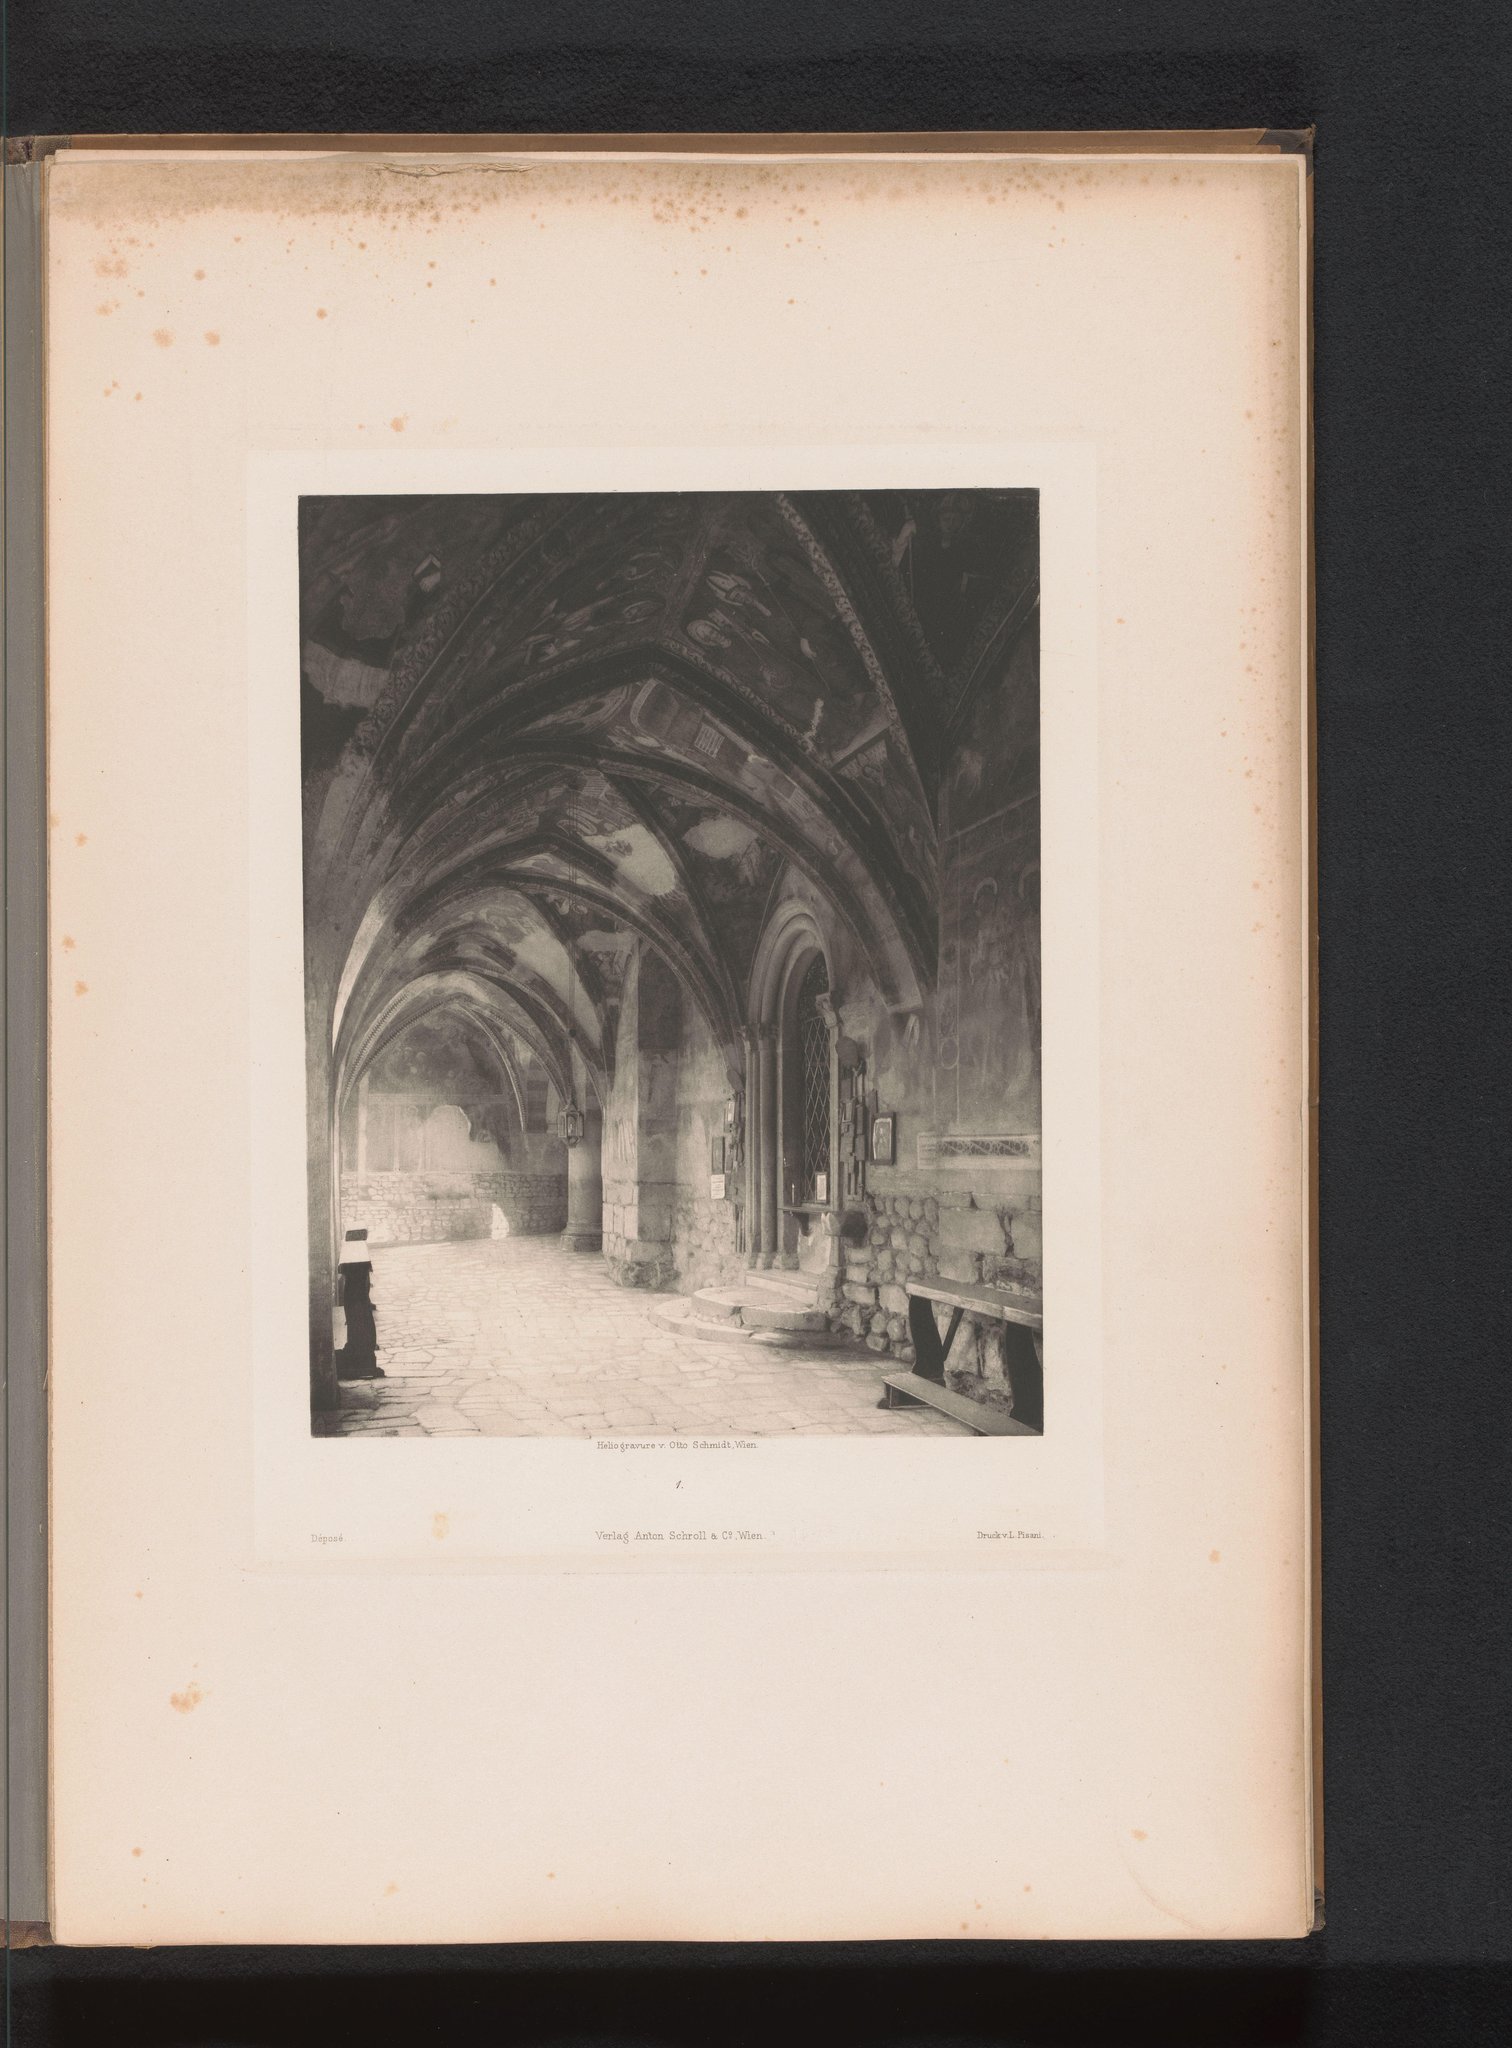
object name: photomechanical print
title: Gezicht op een kruisgang met fresco's in Bressanone, Italië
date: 1886-1891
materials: paper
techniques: photoaquatint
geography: vienna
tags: interior of church, picture, painting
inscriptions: number: ‘1.’, inscription: ‘Déposé.’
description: Deze prent maakt deel uit van een omslag met dertig prenten en drie tekstbladen.